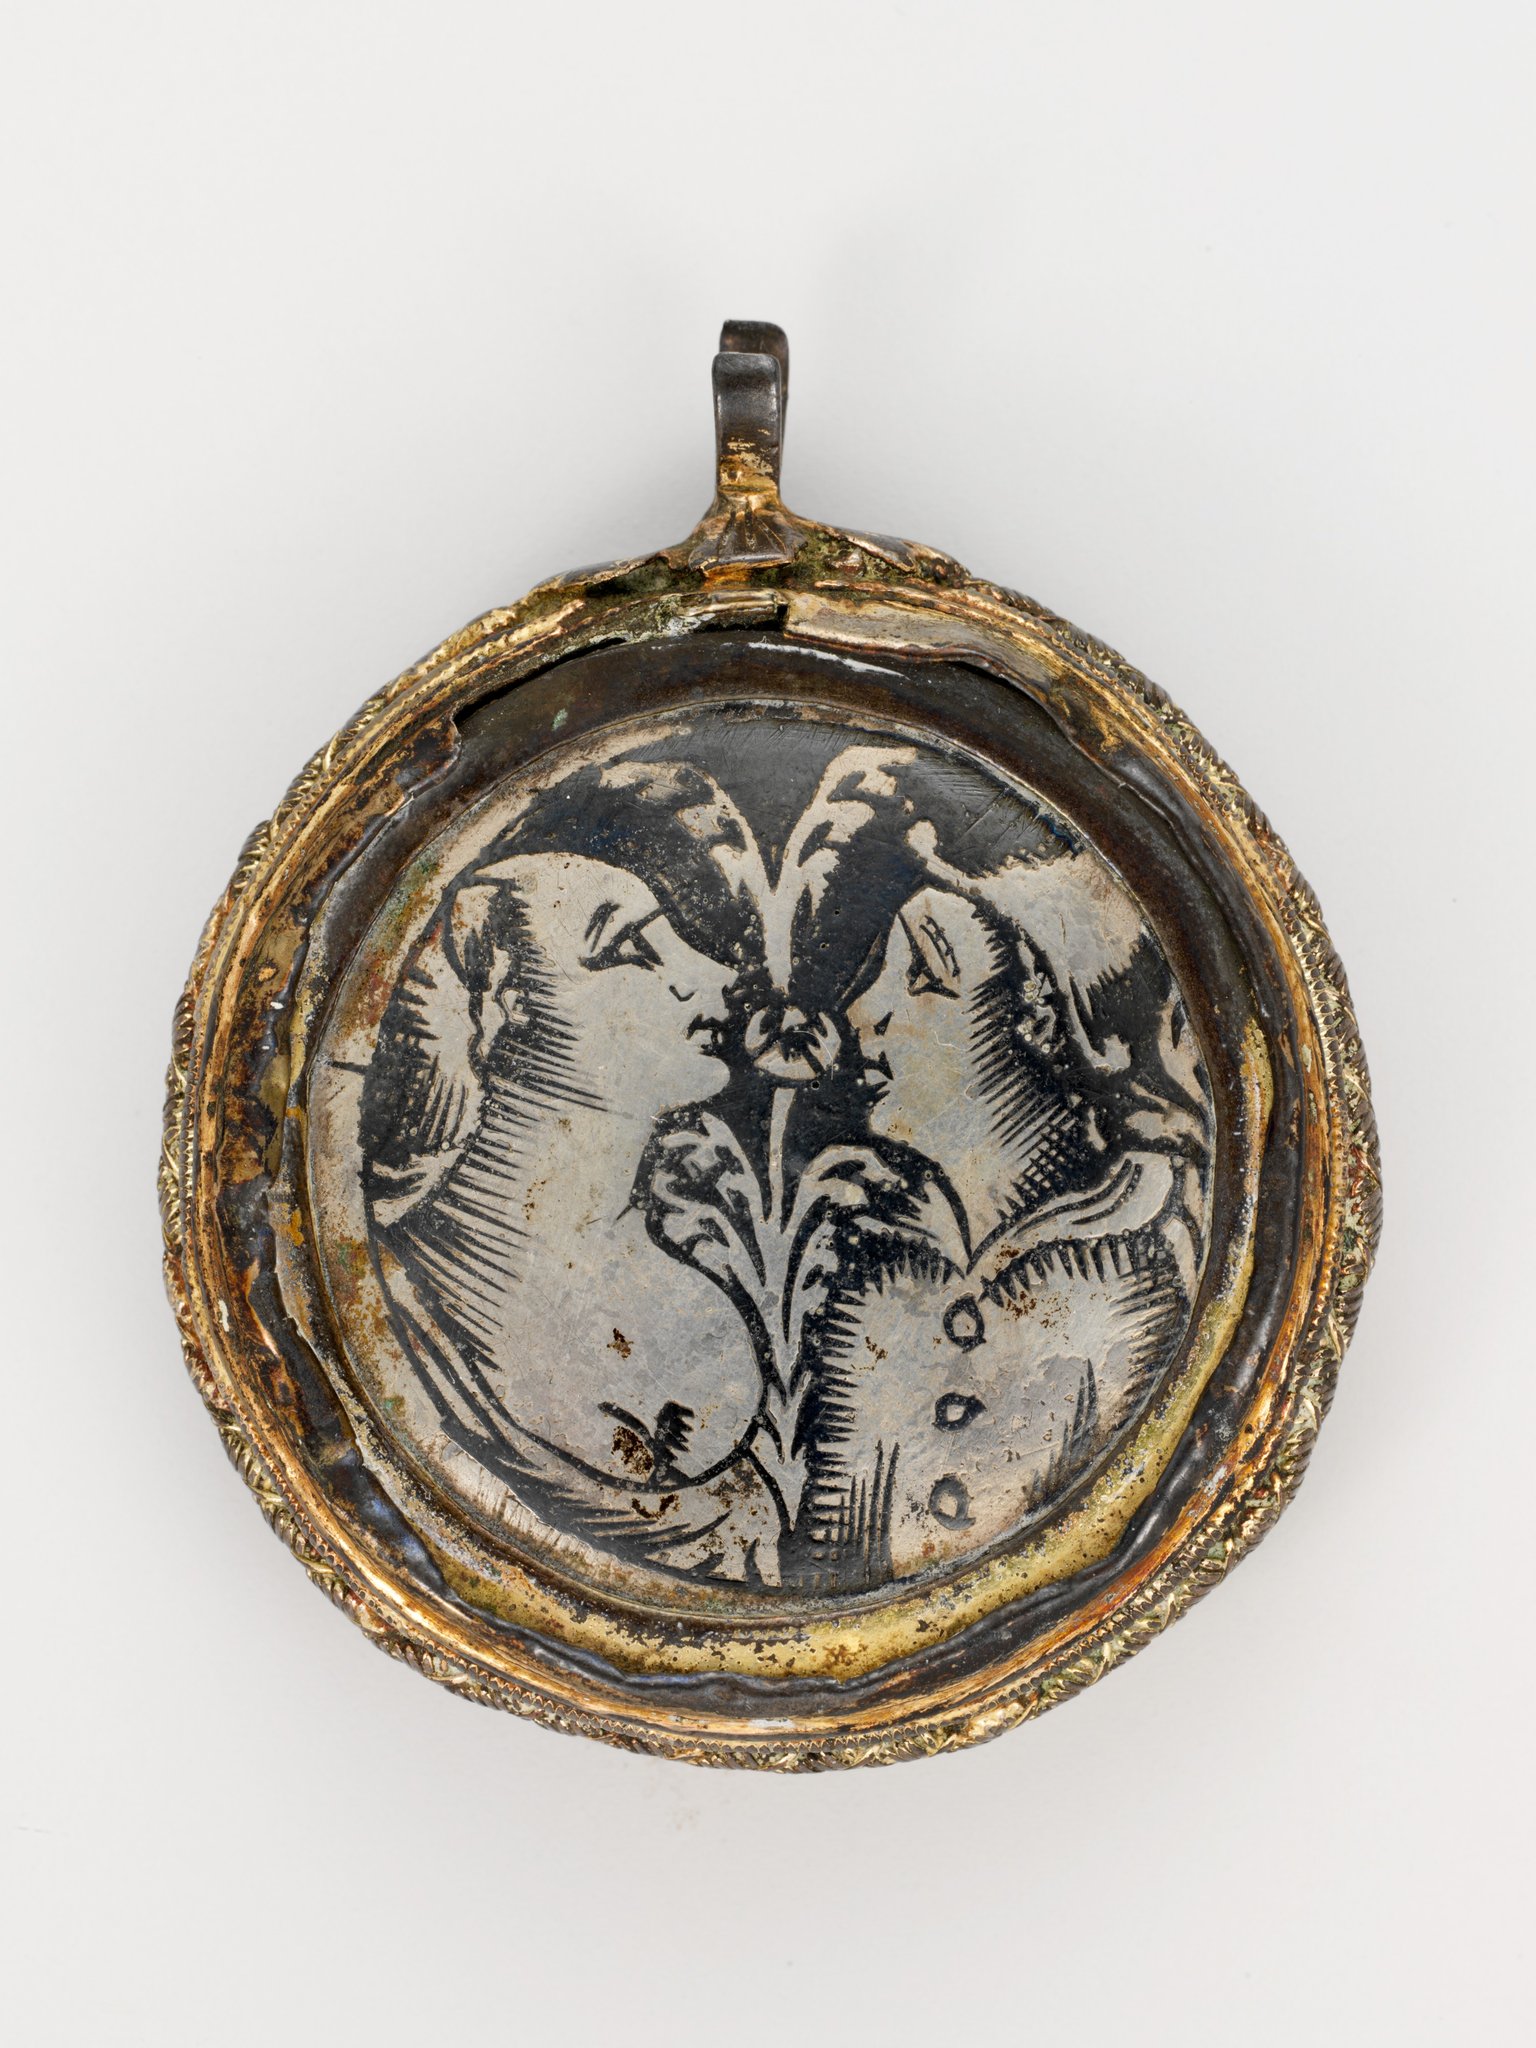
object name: pendant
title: Pendant (one of a pair)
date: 1451-1500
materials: silver gilt, niello, silver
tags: men,women